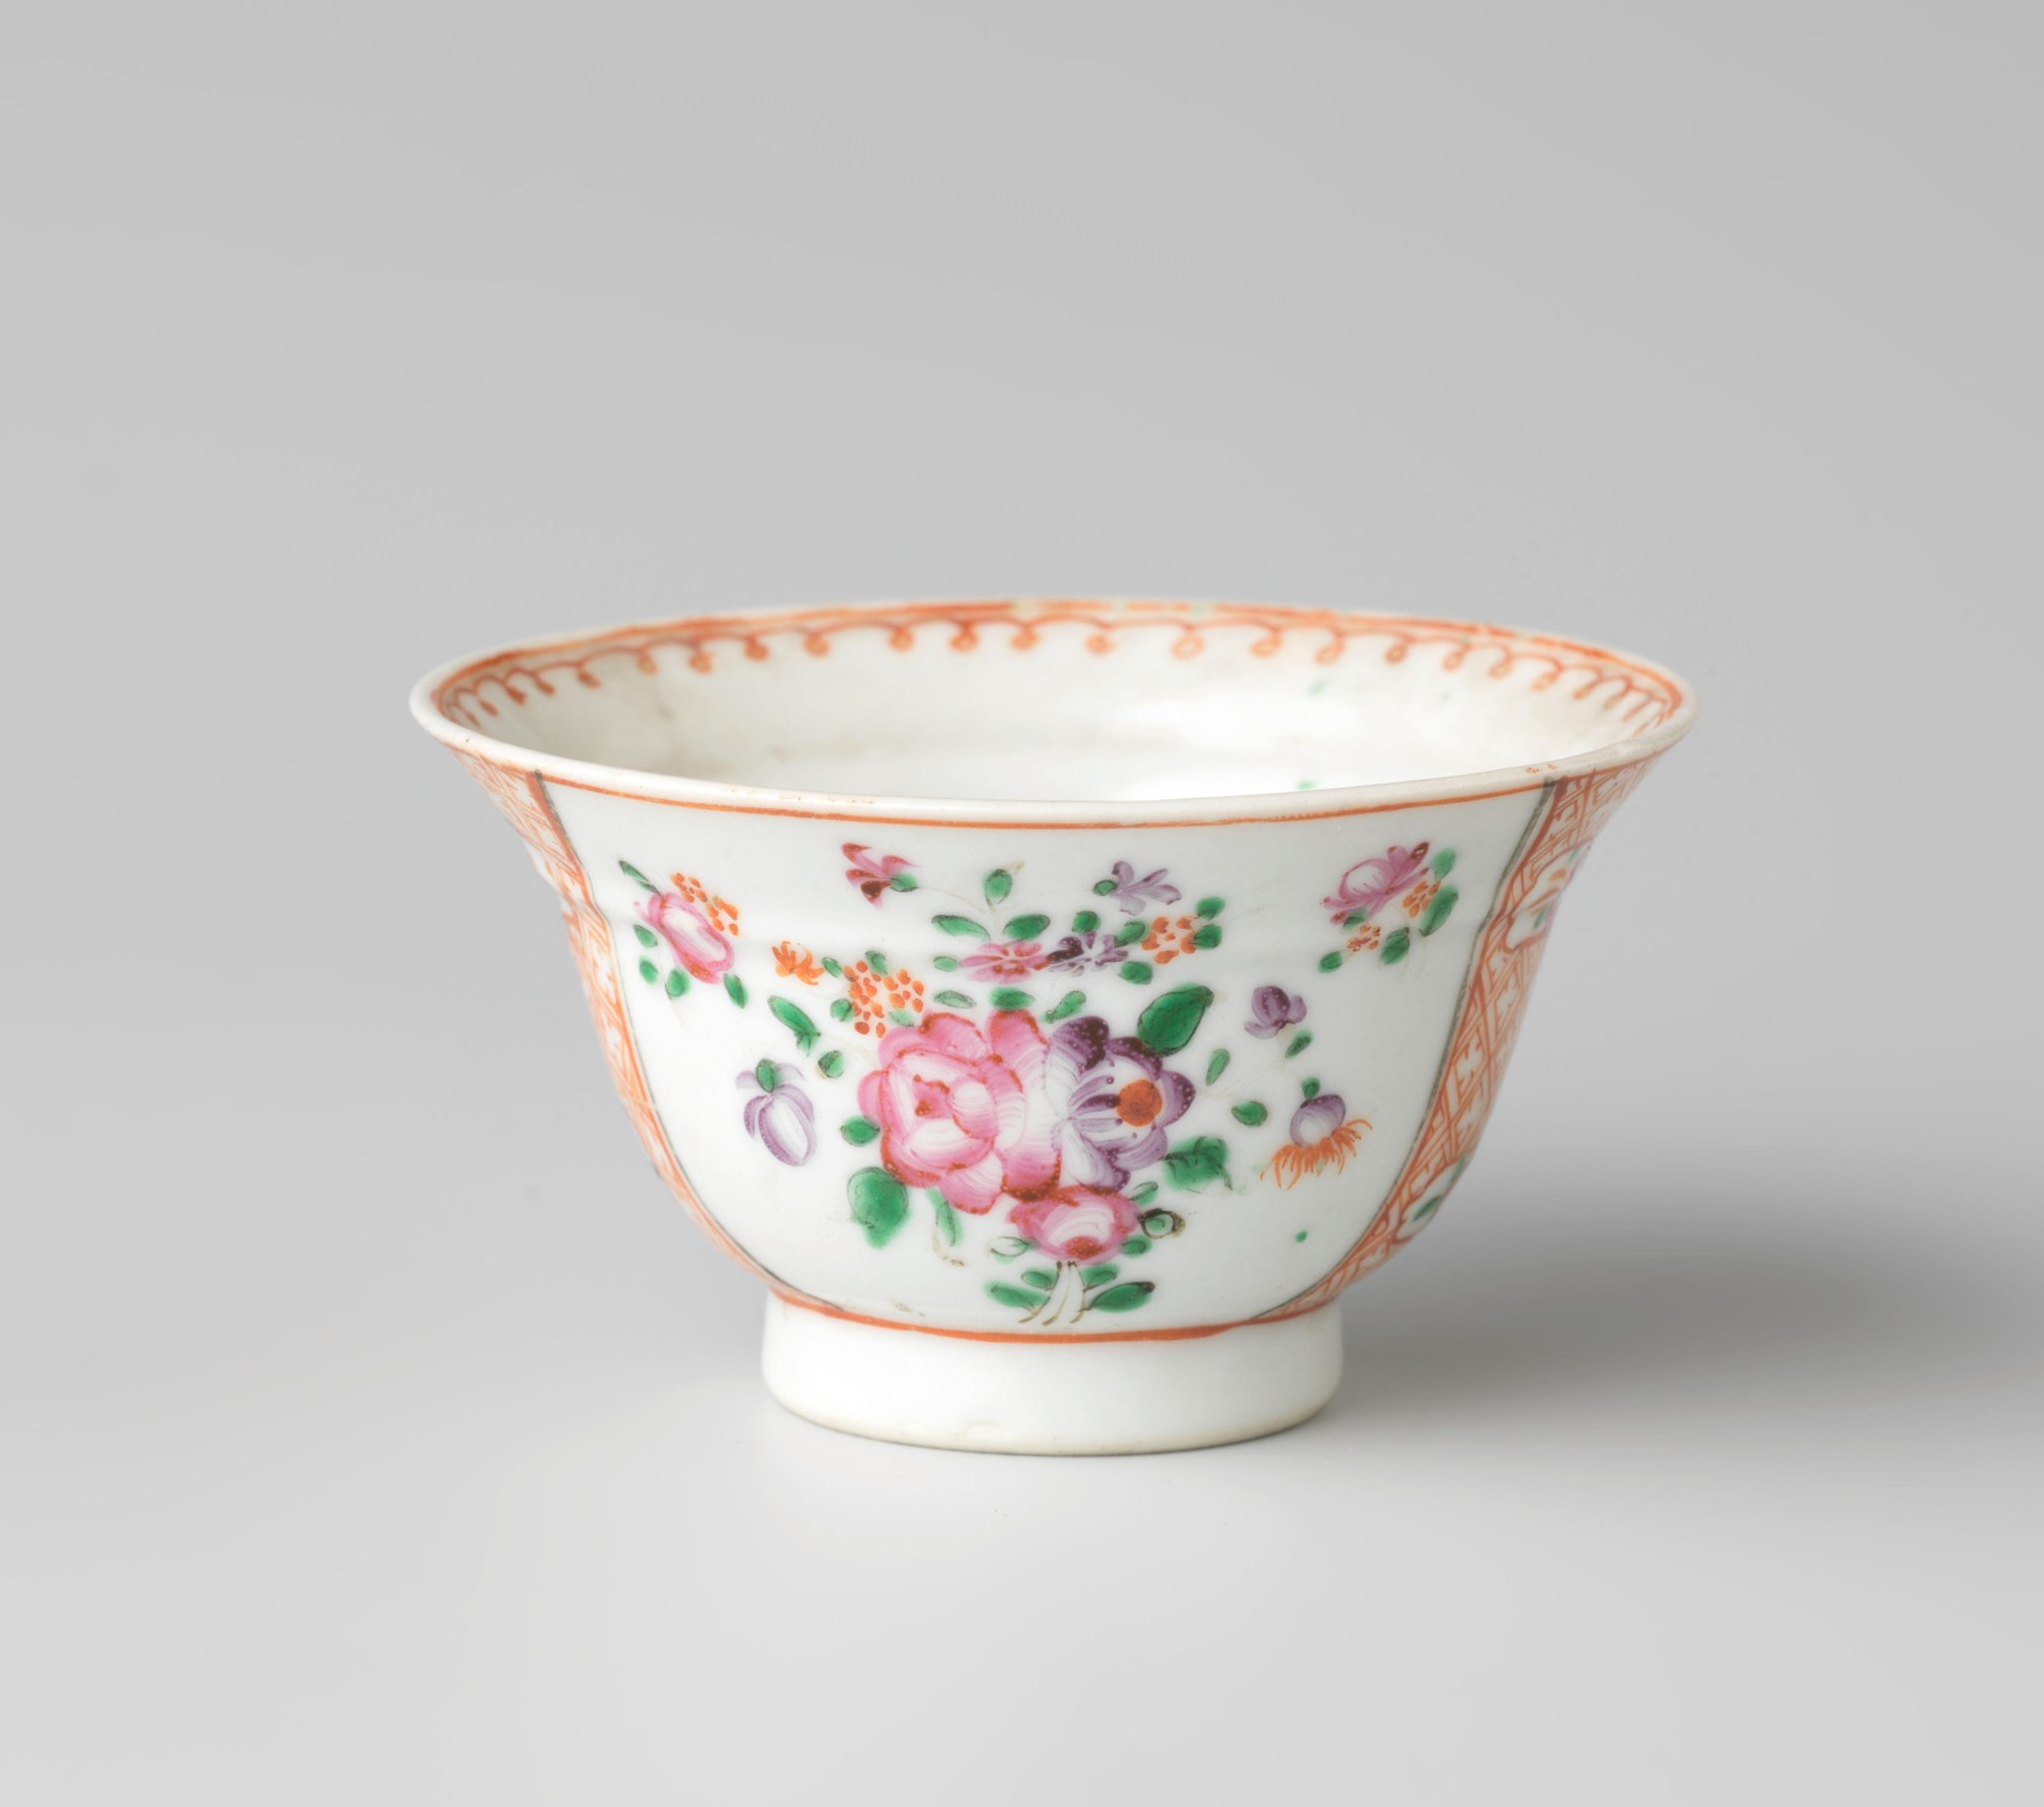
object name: covered cup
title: Bell-shaped cup with bouquets and floral scrolls on a diaper-patters ground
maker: Anonymous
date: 1775-1799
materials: glaze, gold, paint, porcelain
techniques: firing, gilding, turning, vitrification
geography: china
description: Klokvormige dekselkop van porselein, beschilderd op het glazuur in rood, roze, groen, zwart en goud. Op de wand een boeket met verschillende bloemen, omgeven door vier kleinere boeketten; de rand met bloemranken in langwerpige cartouches uitgespaard in een achtergrond van servetwerk. Famille rose.